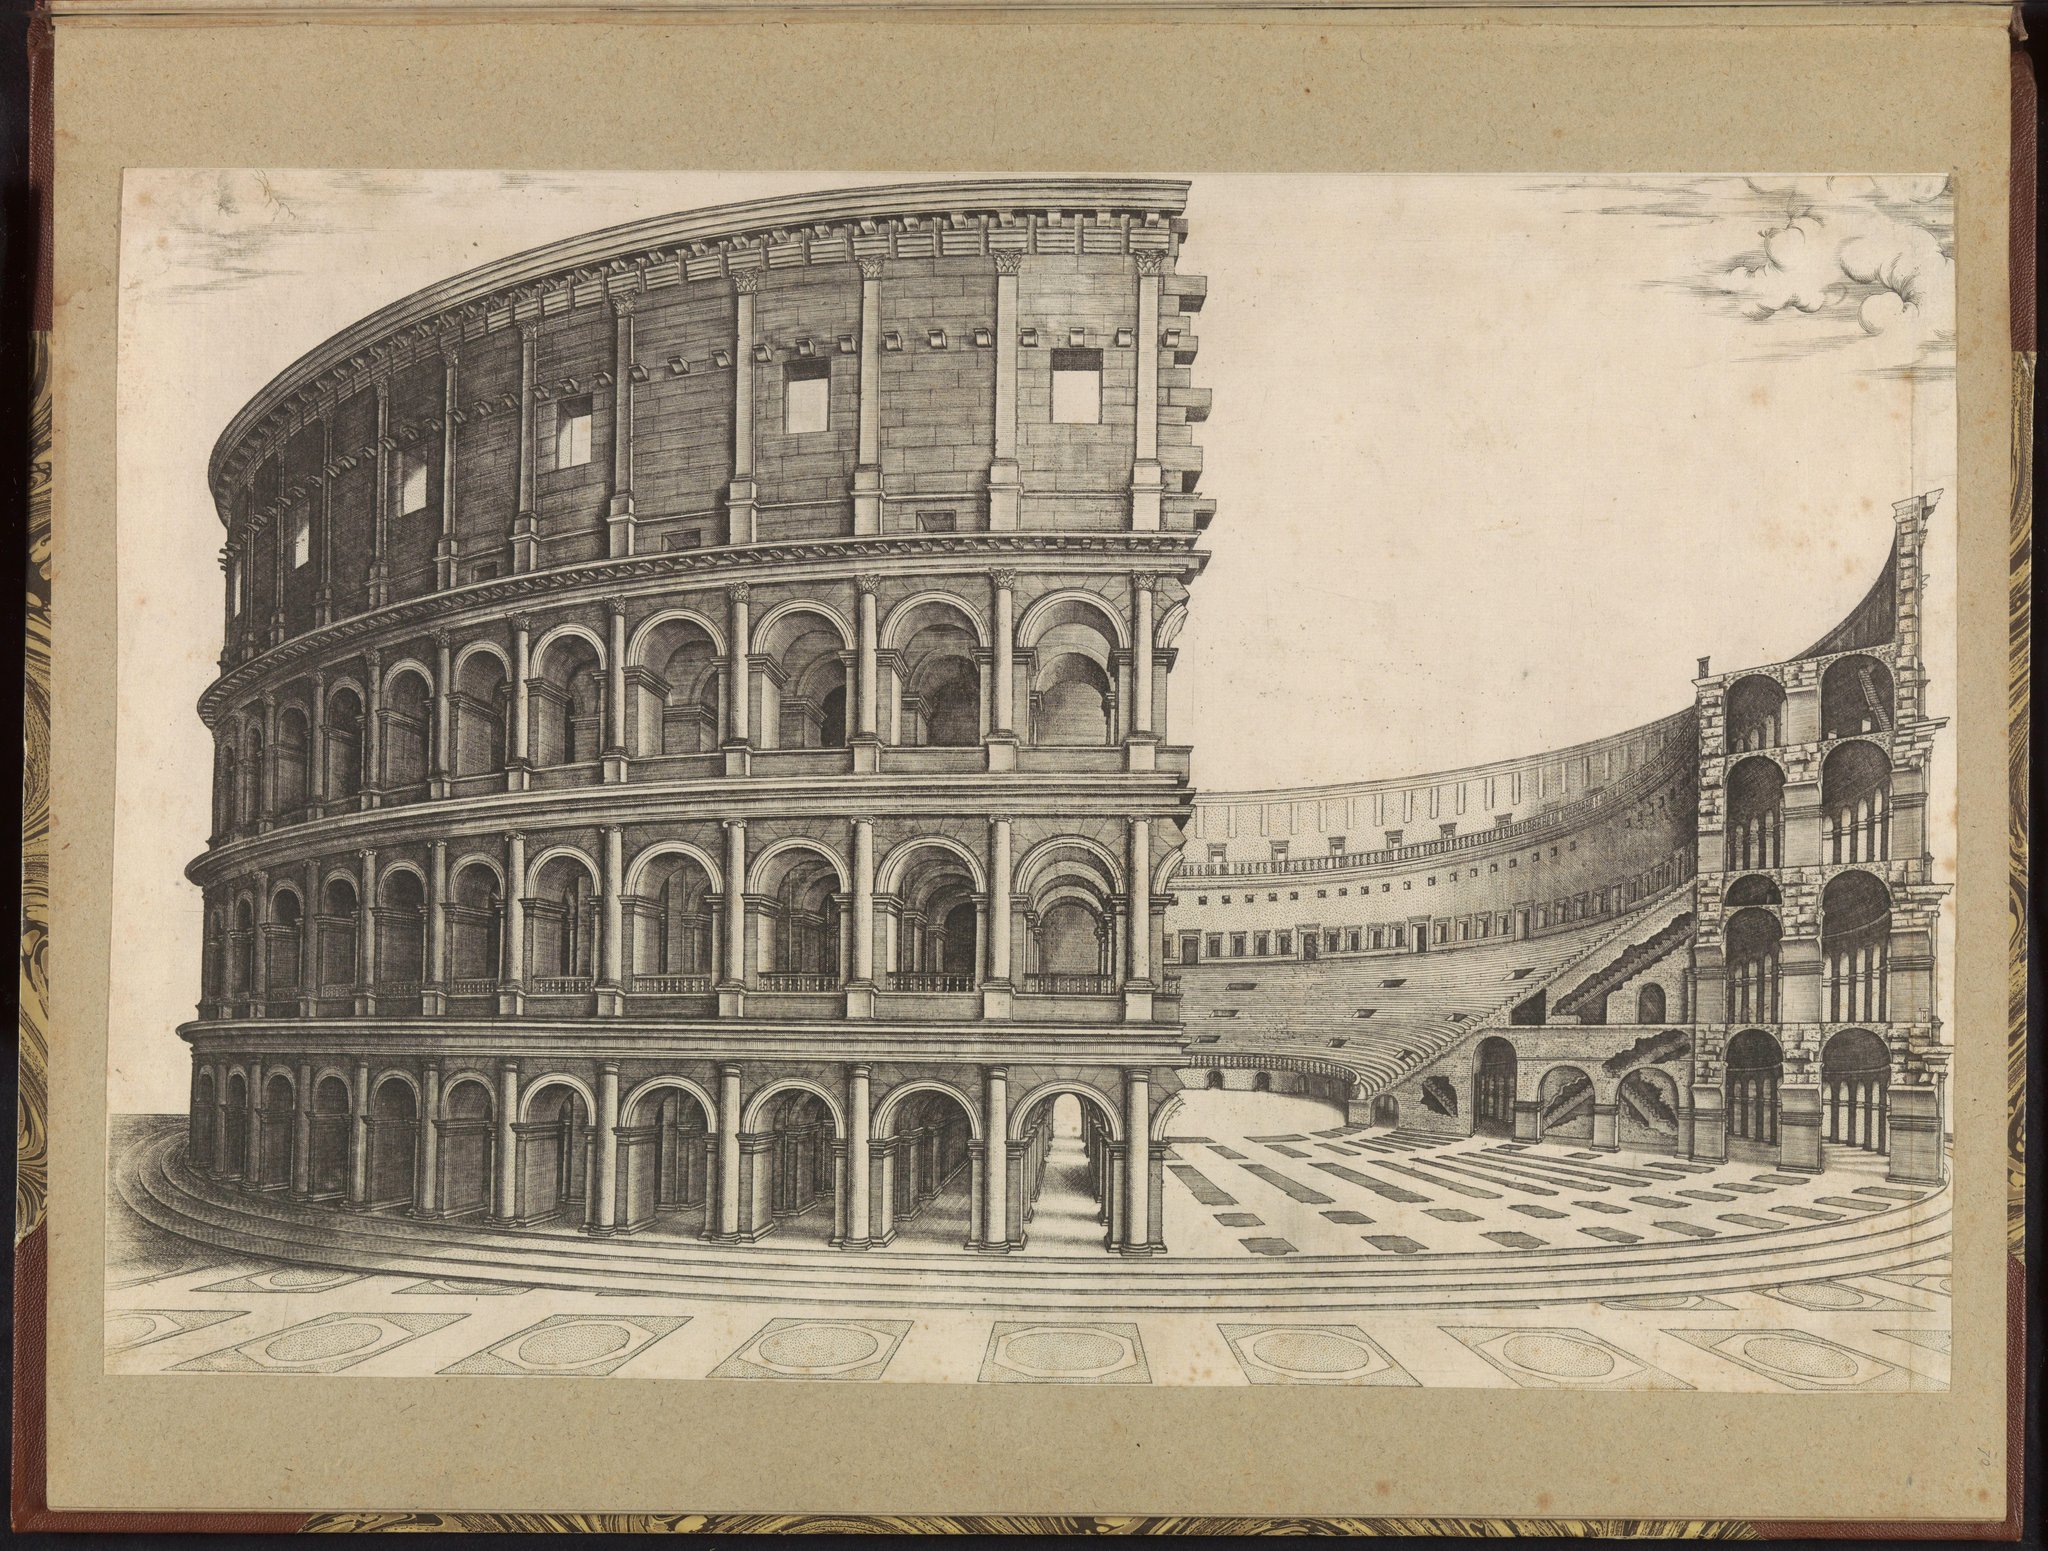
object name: album leaf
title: Colosseum te Rome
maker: Anonymous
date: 1500-1599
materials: paper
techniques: engraving, etching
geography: italy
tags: theatre (building) - aa - open-air performances, representation of real building (either existing or having existed)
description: Deze prent behoort tot het prentcorpus dat bekend staat als de ‘Speculum Romanae Magnificentiae’ (‘Spiegel van Romeinse pracht’). Dit corpus, bestaande uit prenten met voorstellingen van kunstwerken en gebouwen uit het antieke en het moderne Rome, vond zijn oorsprong bij uitgevers Antonio Salamanca en Antonio Lafreri. Deze twee buitenlandse uitgevers bundelden hun krachten te Rome in de periode 1553-1563. Hun prenten werden al snel razend populair bij toeristen en verzamelaars, die de prenten individueel of in grote groepen aanschaften. Grote groepen Speculum-prenten werden vaak op aanvraag samengebonden in albums. Er zijn verschillende Speculum-albums overgeleverd die allemaal verschillen van inhoud. Tussen 1573 en 1577 gaf Antonio Lafreri een speciale titelpagina uit (met de titel ‘Speculum Romanae Magnificentiae’) die mensen voor hun verzamelingen konden voegen. Het overlijden van Lafreri in 1577 betekende niet het einde van het corpus. Een groot deel van de koperplaten ging over op Claudio en Stefano Duchetti. De rest raakte verspreid over verschillende andere uitgevers. De populariteit van de Speculum-prenten wist nog geruime periode uitgevers te inspireren tot het laten maken van kopieën en het toevoegen van nieuwe prenten aan het corpus.